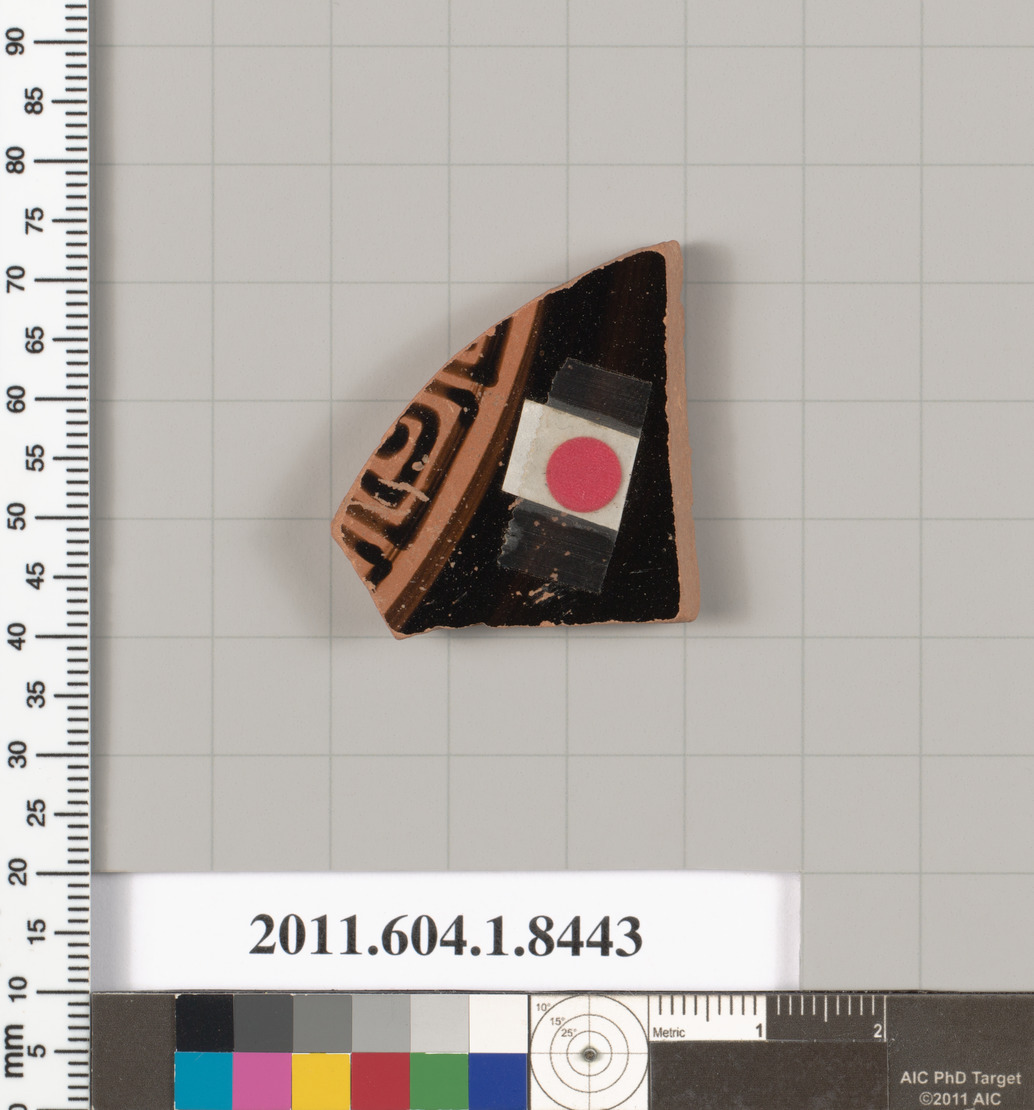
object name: kylix fragment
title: Terracotta fragment of a kylix (drinking cup)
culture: greek, attic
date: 400-376 BCE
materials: terracotta